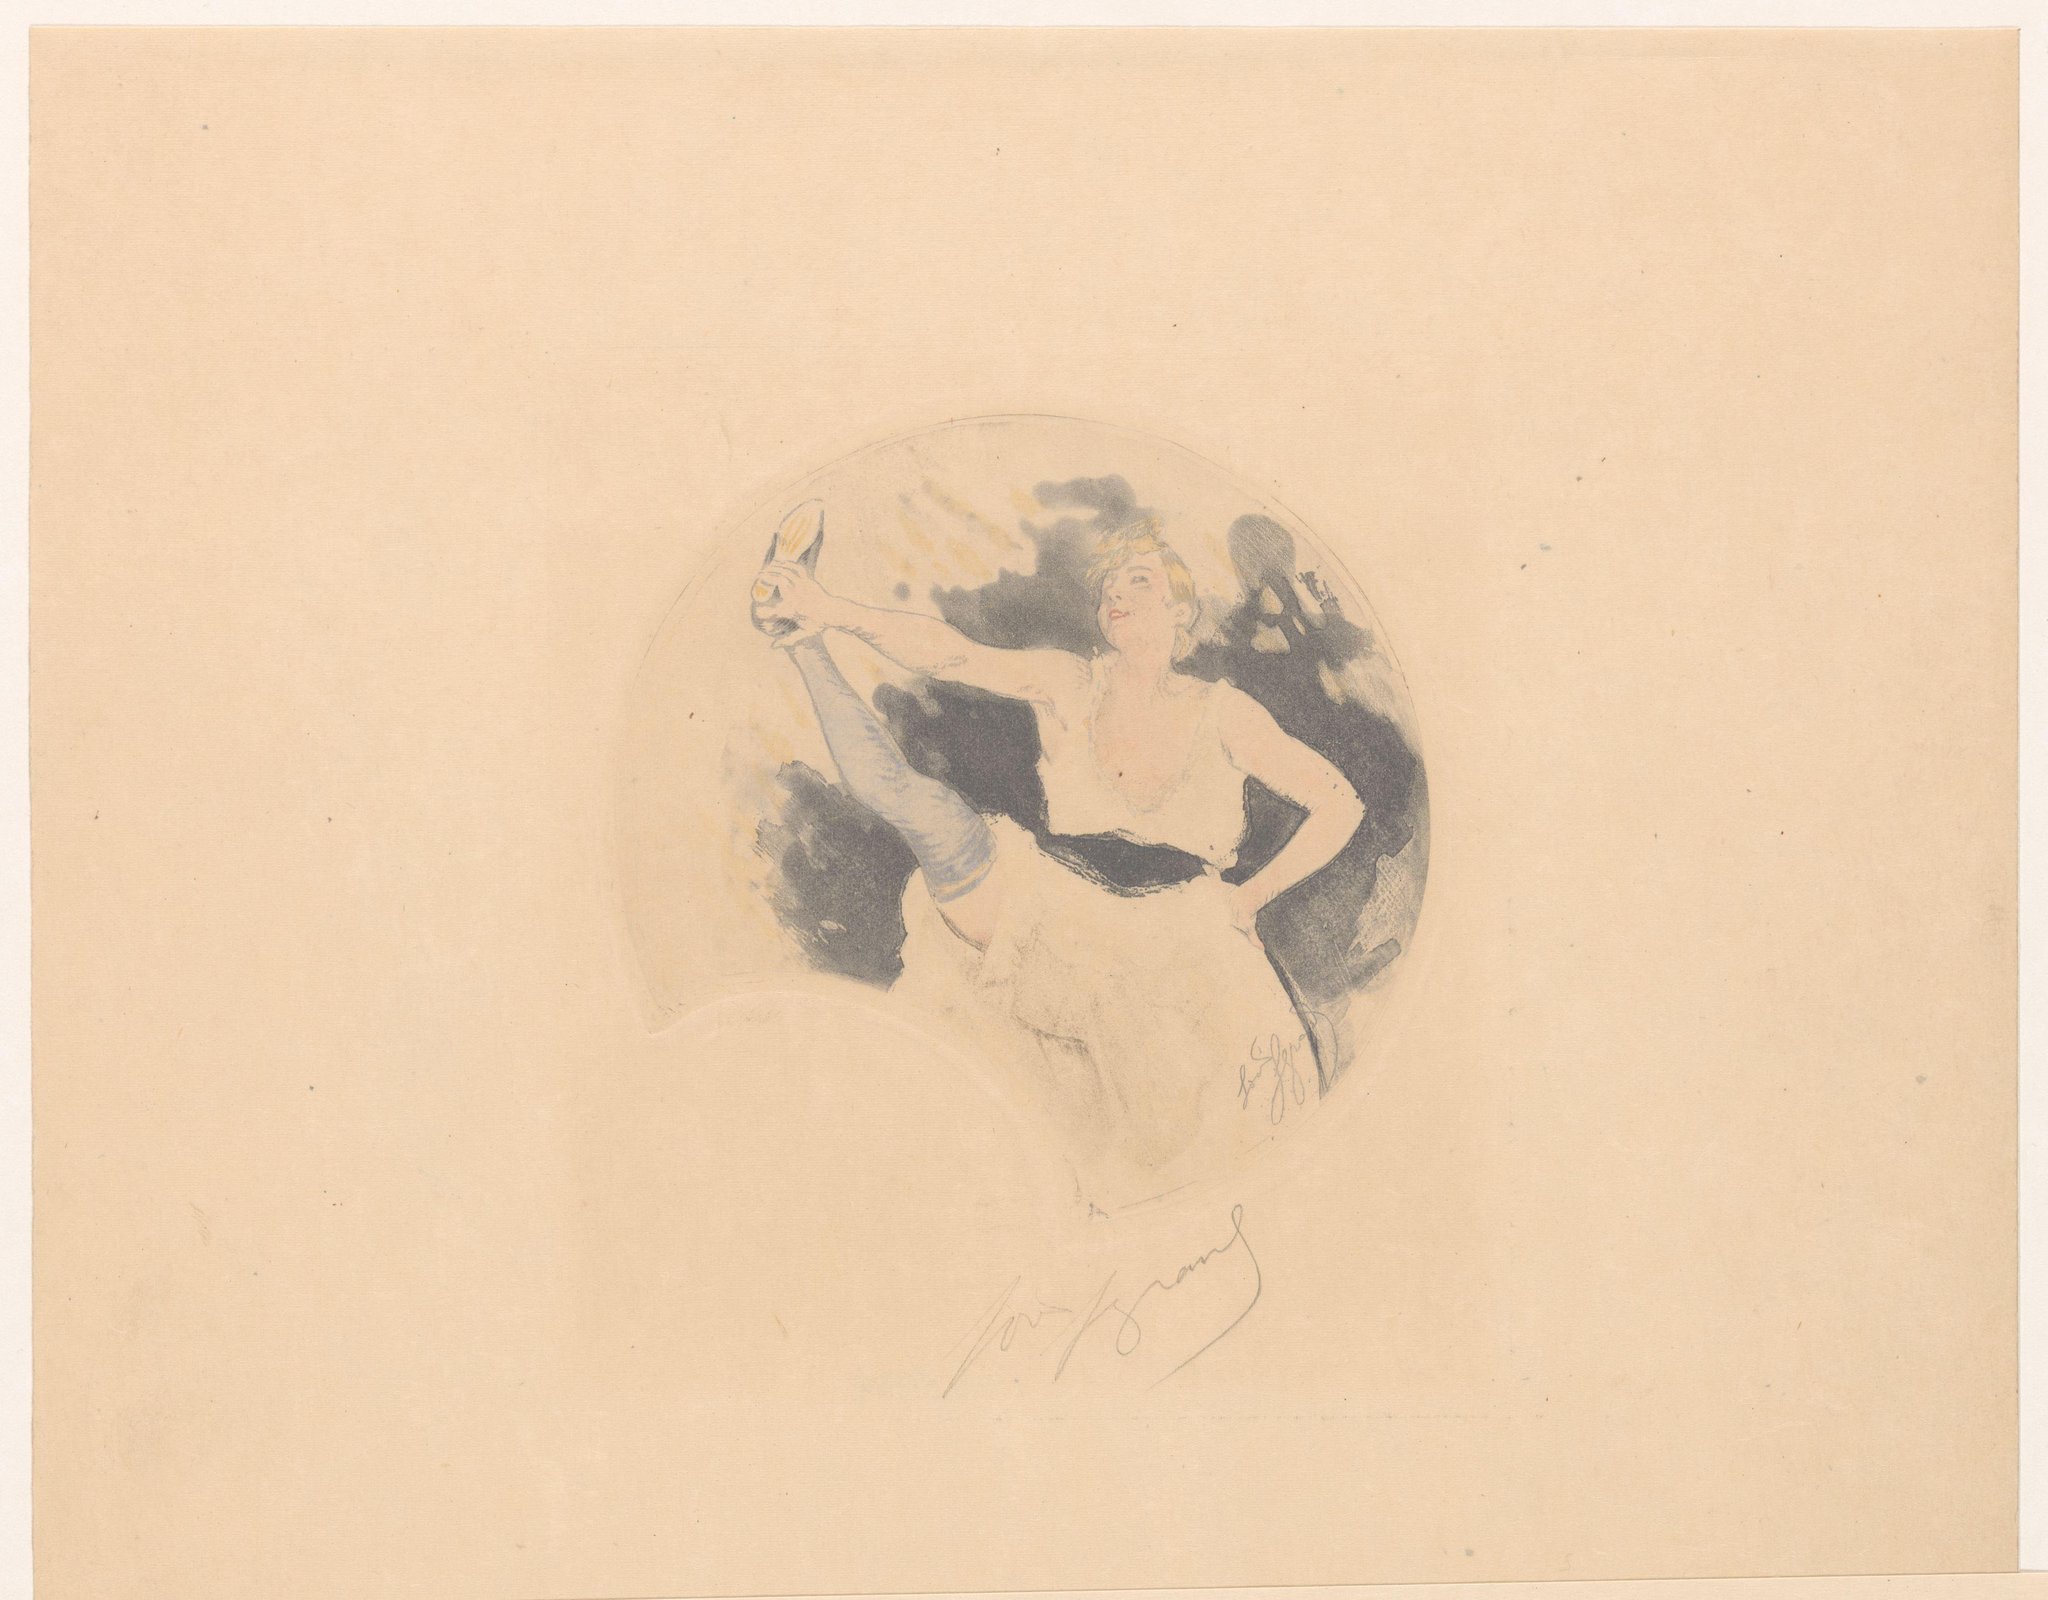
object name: print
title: Danseres met opgeheven been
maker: louis legrand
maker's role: painter, print maker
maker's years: 1863-1951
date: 1892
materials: paper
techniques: etching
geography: france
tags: female dancer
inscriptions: collector's mark: Lugt 2228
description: Titelpagina voor: Legrand, Louis. Cours de danse fin de siècle. Parijs: Edouard Dentu, 1892.